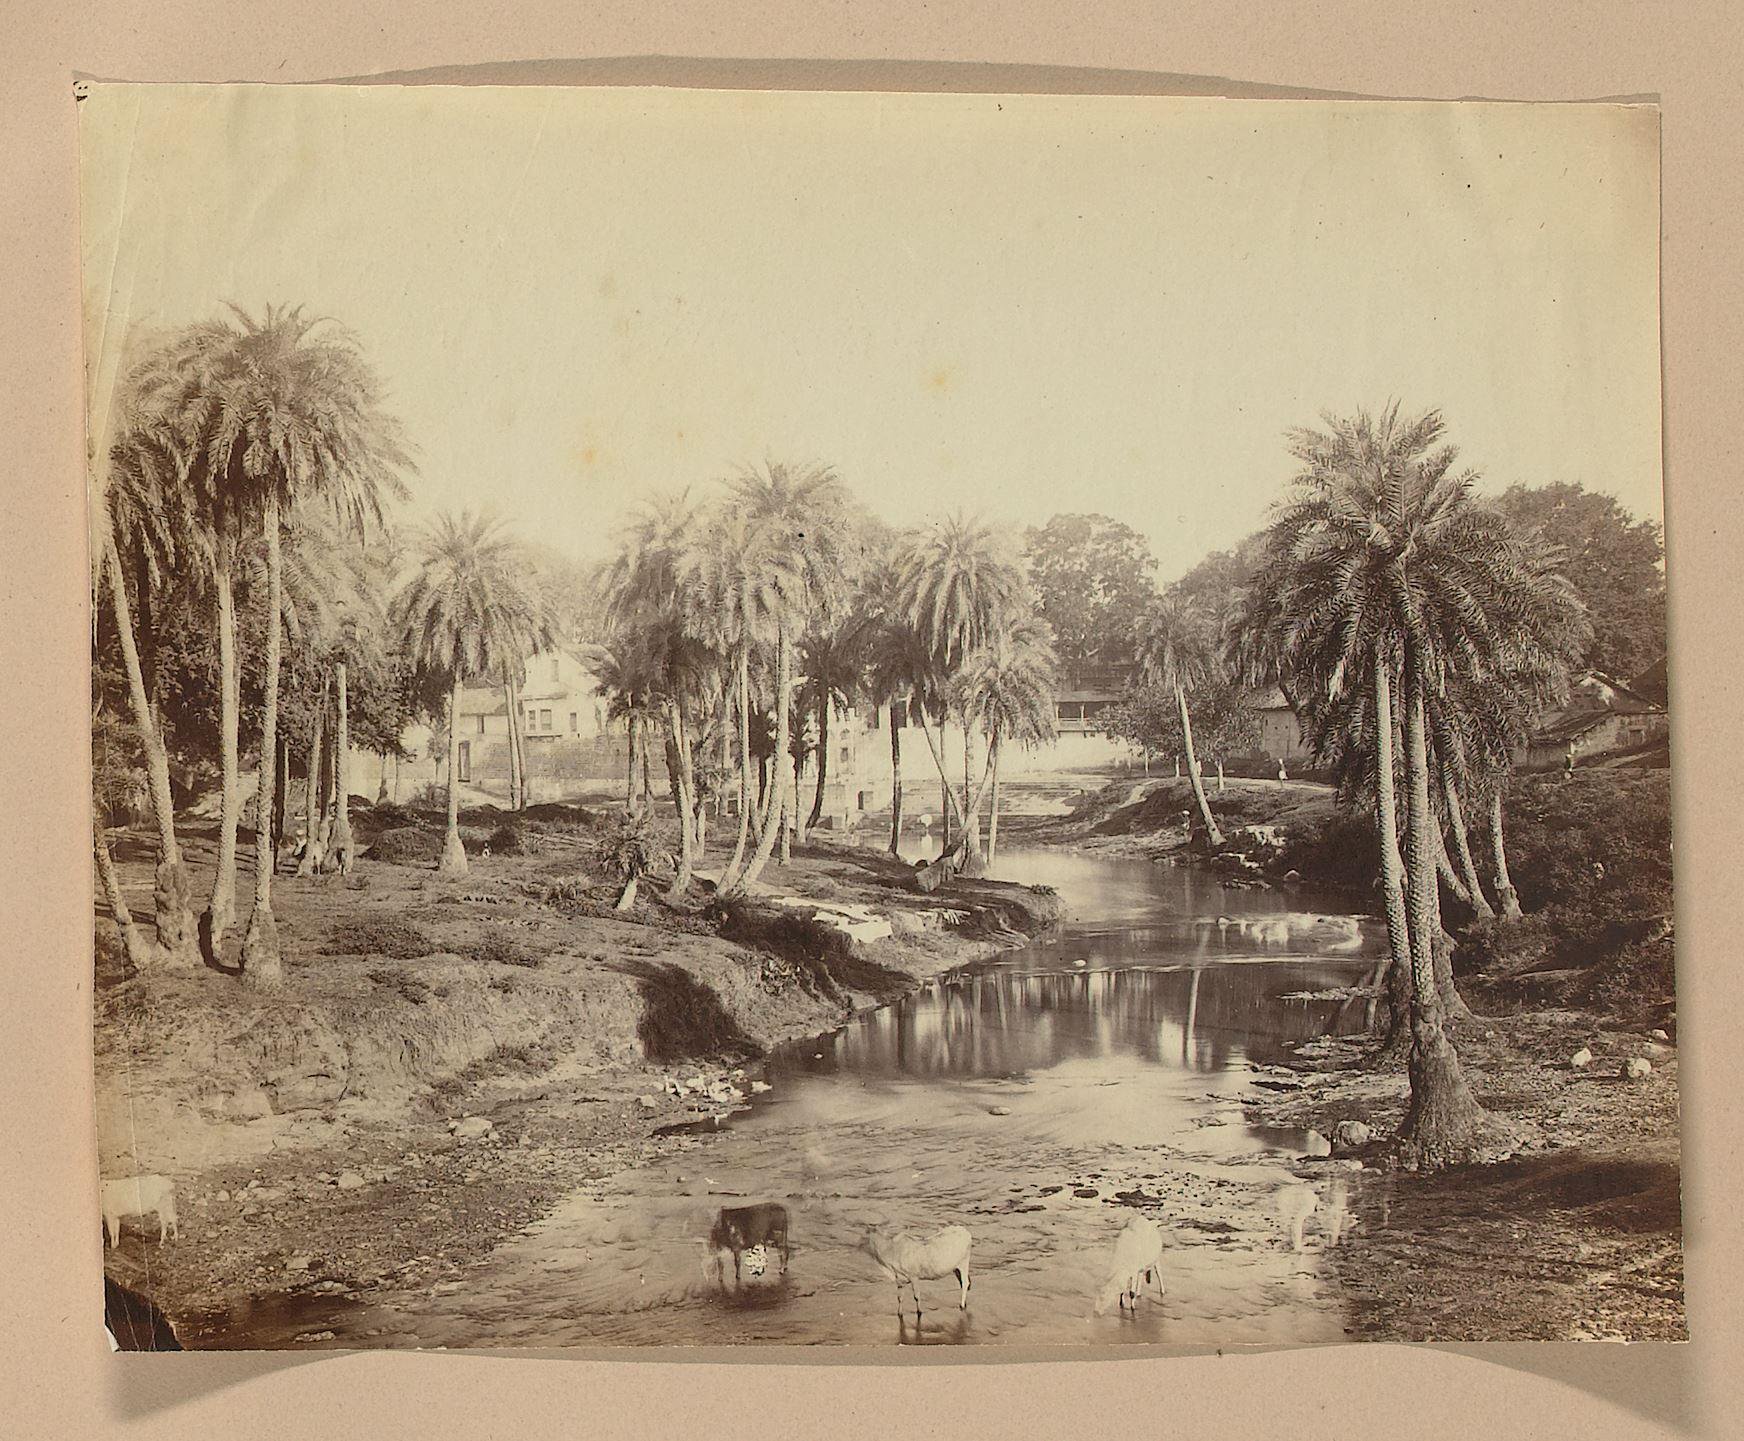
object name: photograph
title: India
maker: james john waterhouse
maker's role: fotograaf, luitenant, officier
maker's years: 1842-1928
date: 1860-1865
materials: cardboard, paper, photographic support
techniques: albumen print